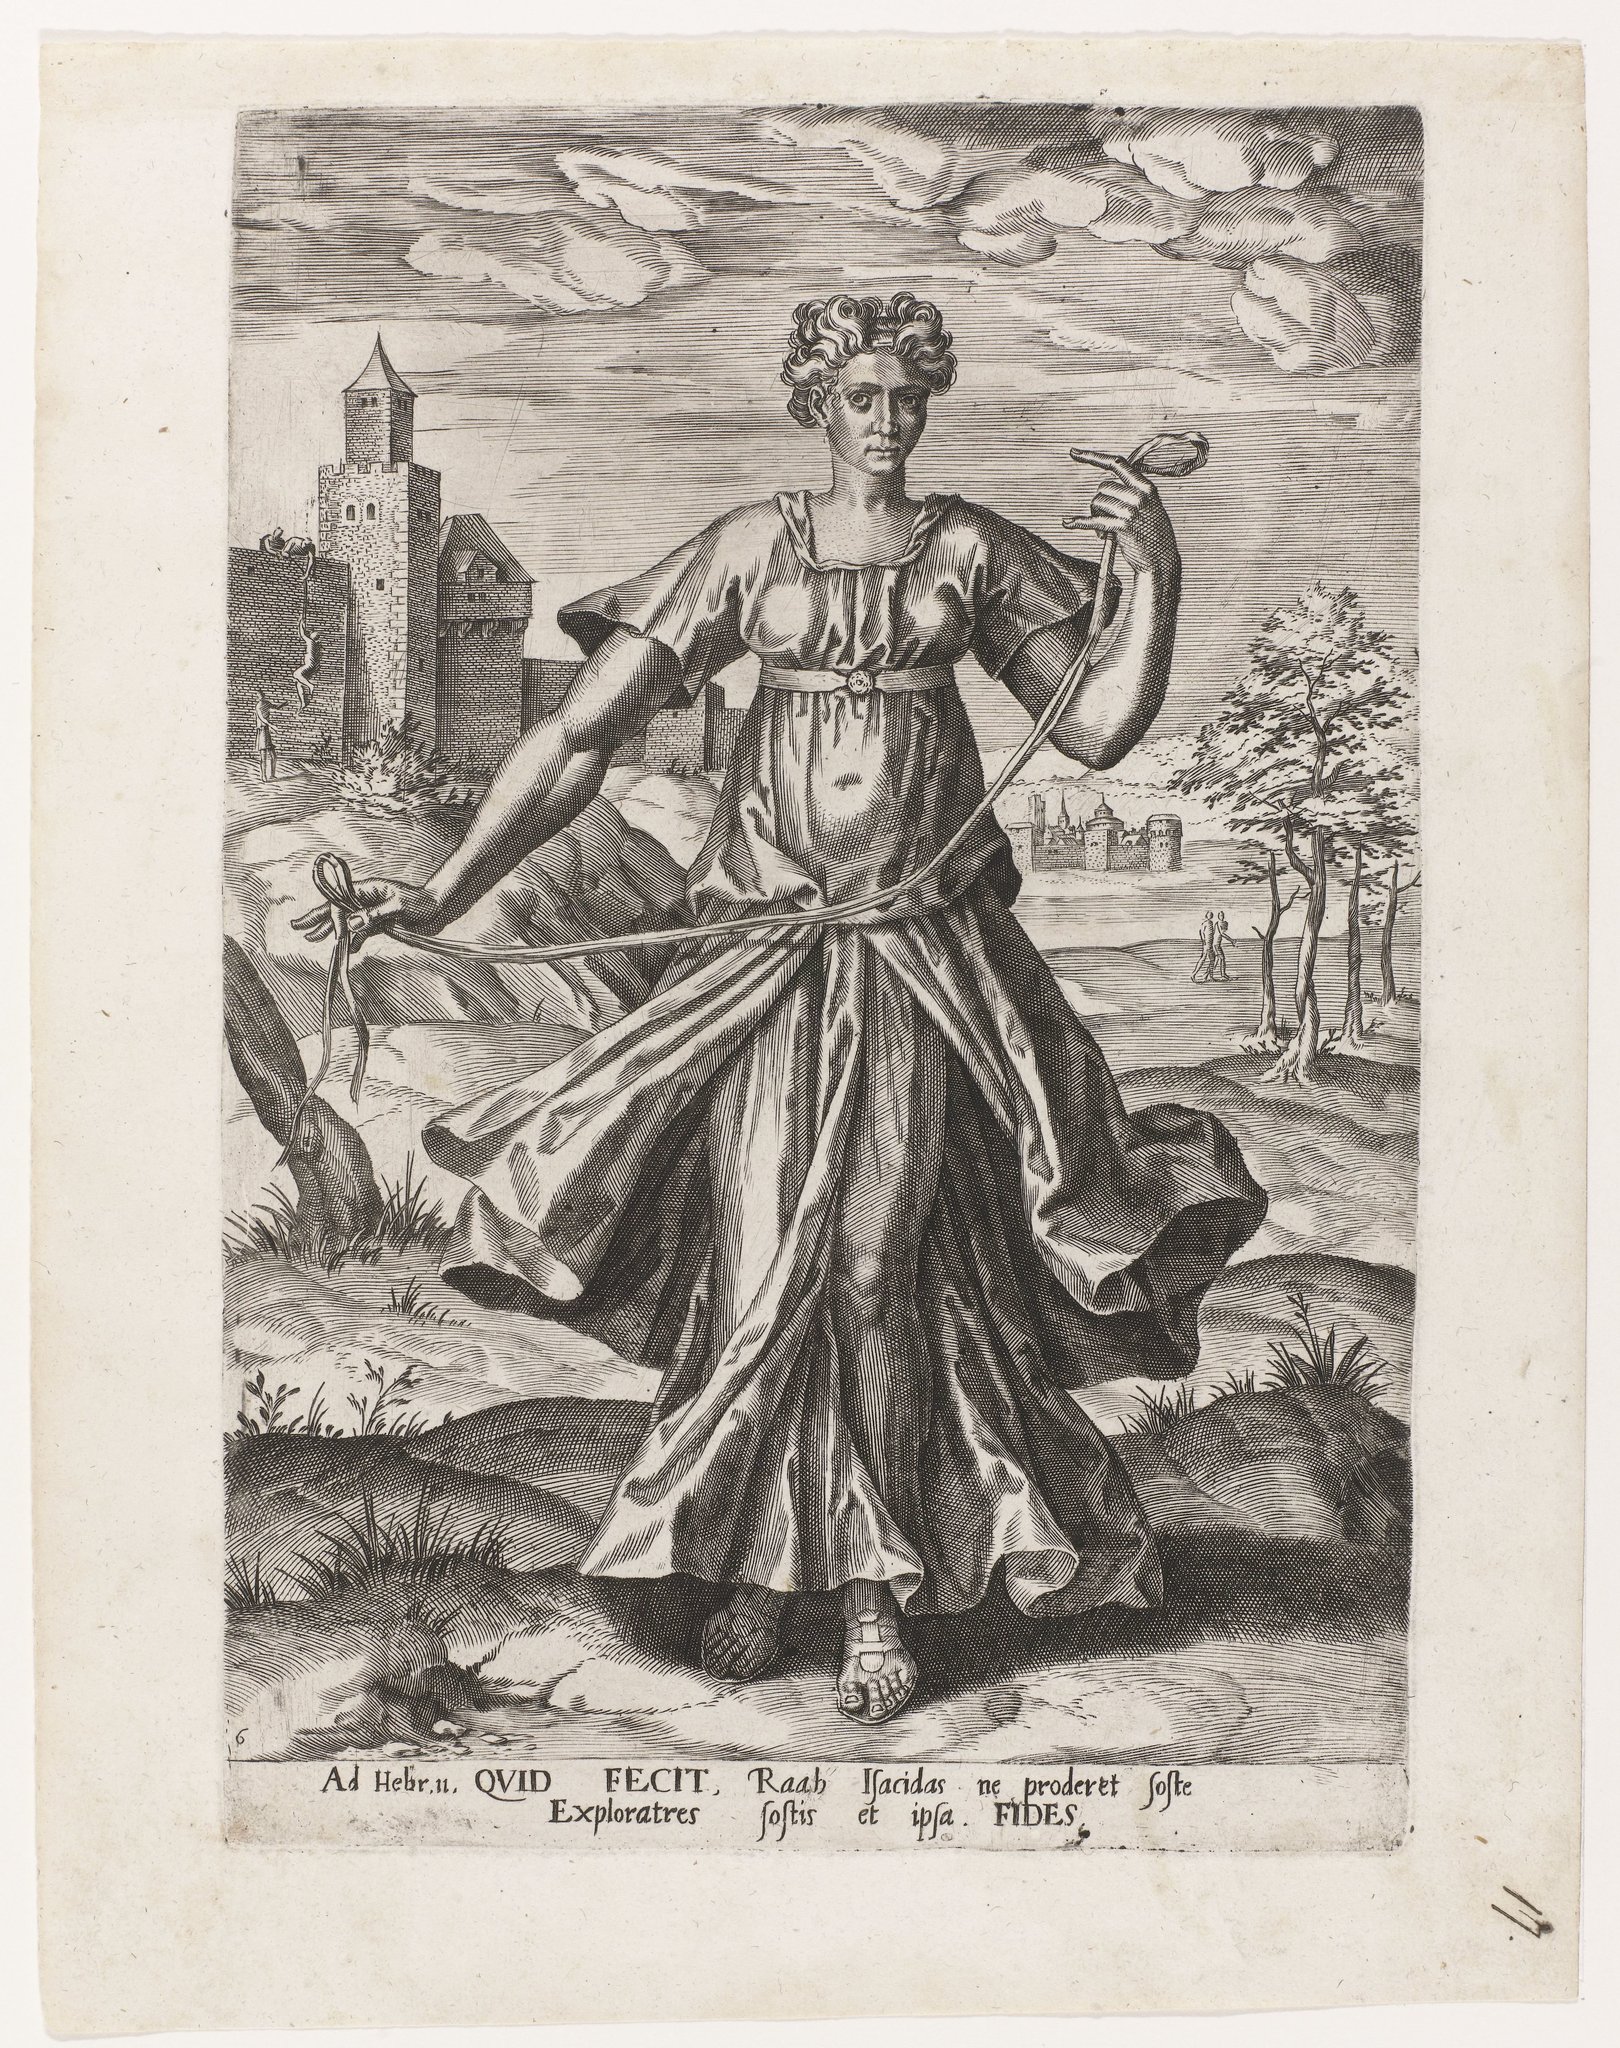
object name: print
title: Rachab en de verspieders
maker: pieter jalhea furnius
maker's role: print maker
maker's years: 1540-1626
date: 1550-1625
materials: paper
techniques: engraving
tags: rahab, whose house was built in the city wall, lets the spies down from the window by means of a red rope, rahab (not in biblical context); possible attributes: red rope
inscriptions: collector's mark: Lugt 2760, collector's mark: Lugt 2228, number: ‘17’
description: De hoer Rachab woonde aan de rand van de stad Jericho. Zij verborg twee spionnen van Jozua in haar huis. Op de voorgrond staat zij met het touw in de handen waarmee zij de spionnen liet ontsnappen. Links op de achtergrond is deze ontsnapping te zien. Onder de afbeelding staat een tweeregelige tekst in het Latijn, links boven de marge genummerd: 6. De prent maakt deel uit van een serie prenten over de Brief aan de Hebreeën hoofdstuk 11.